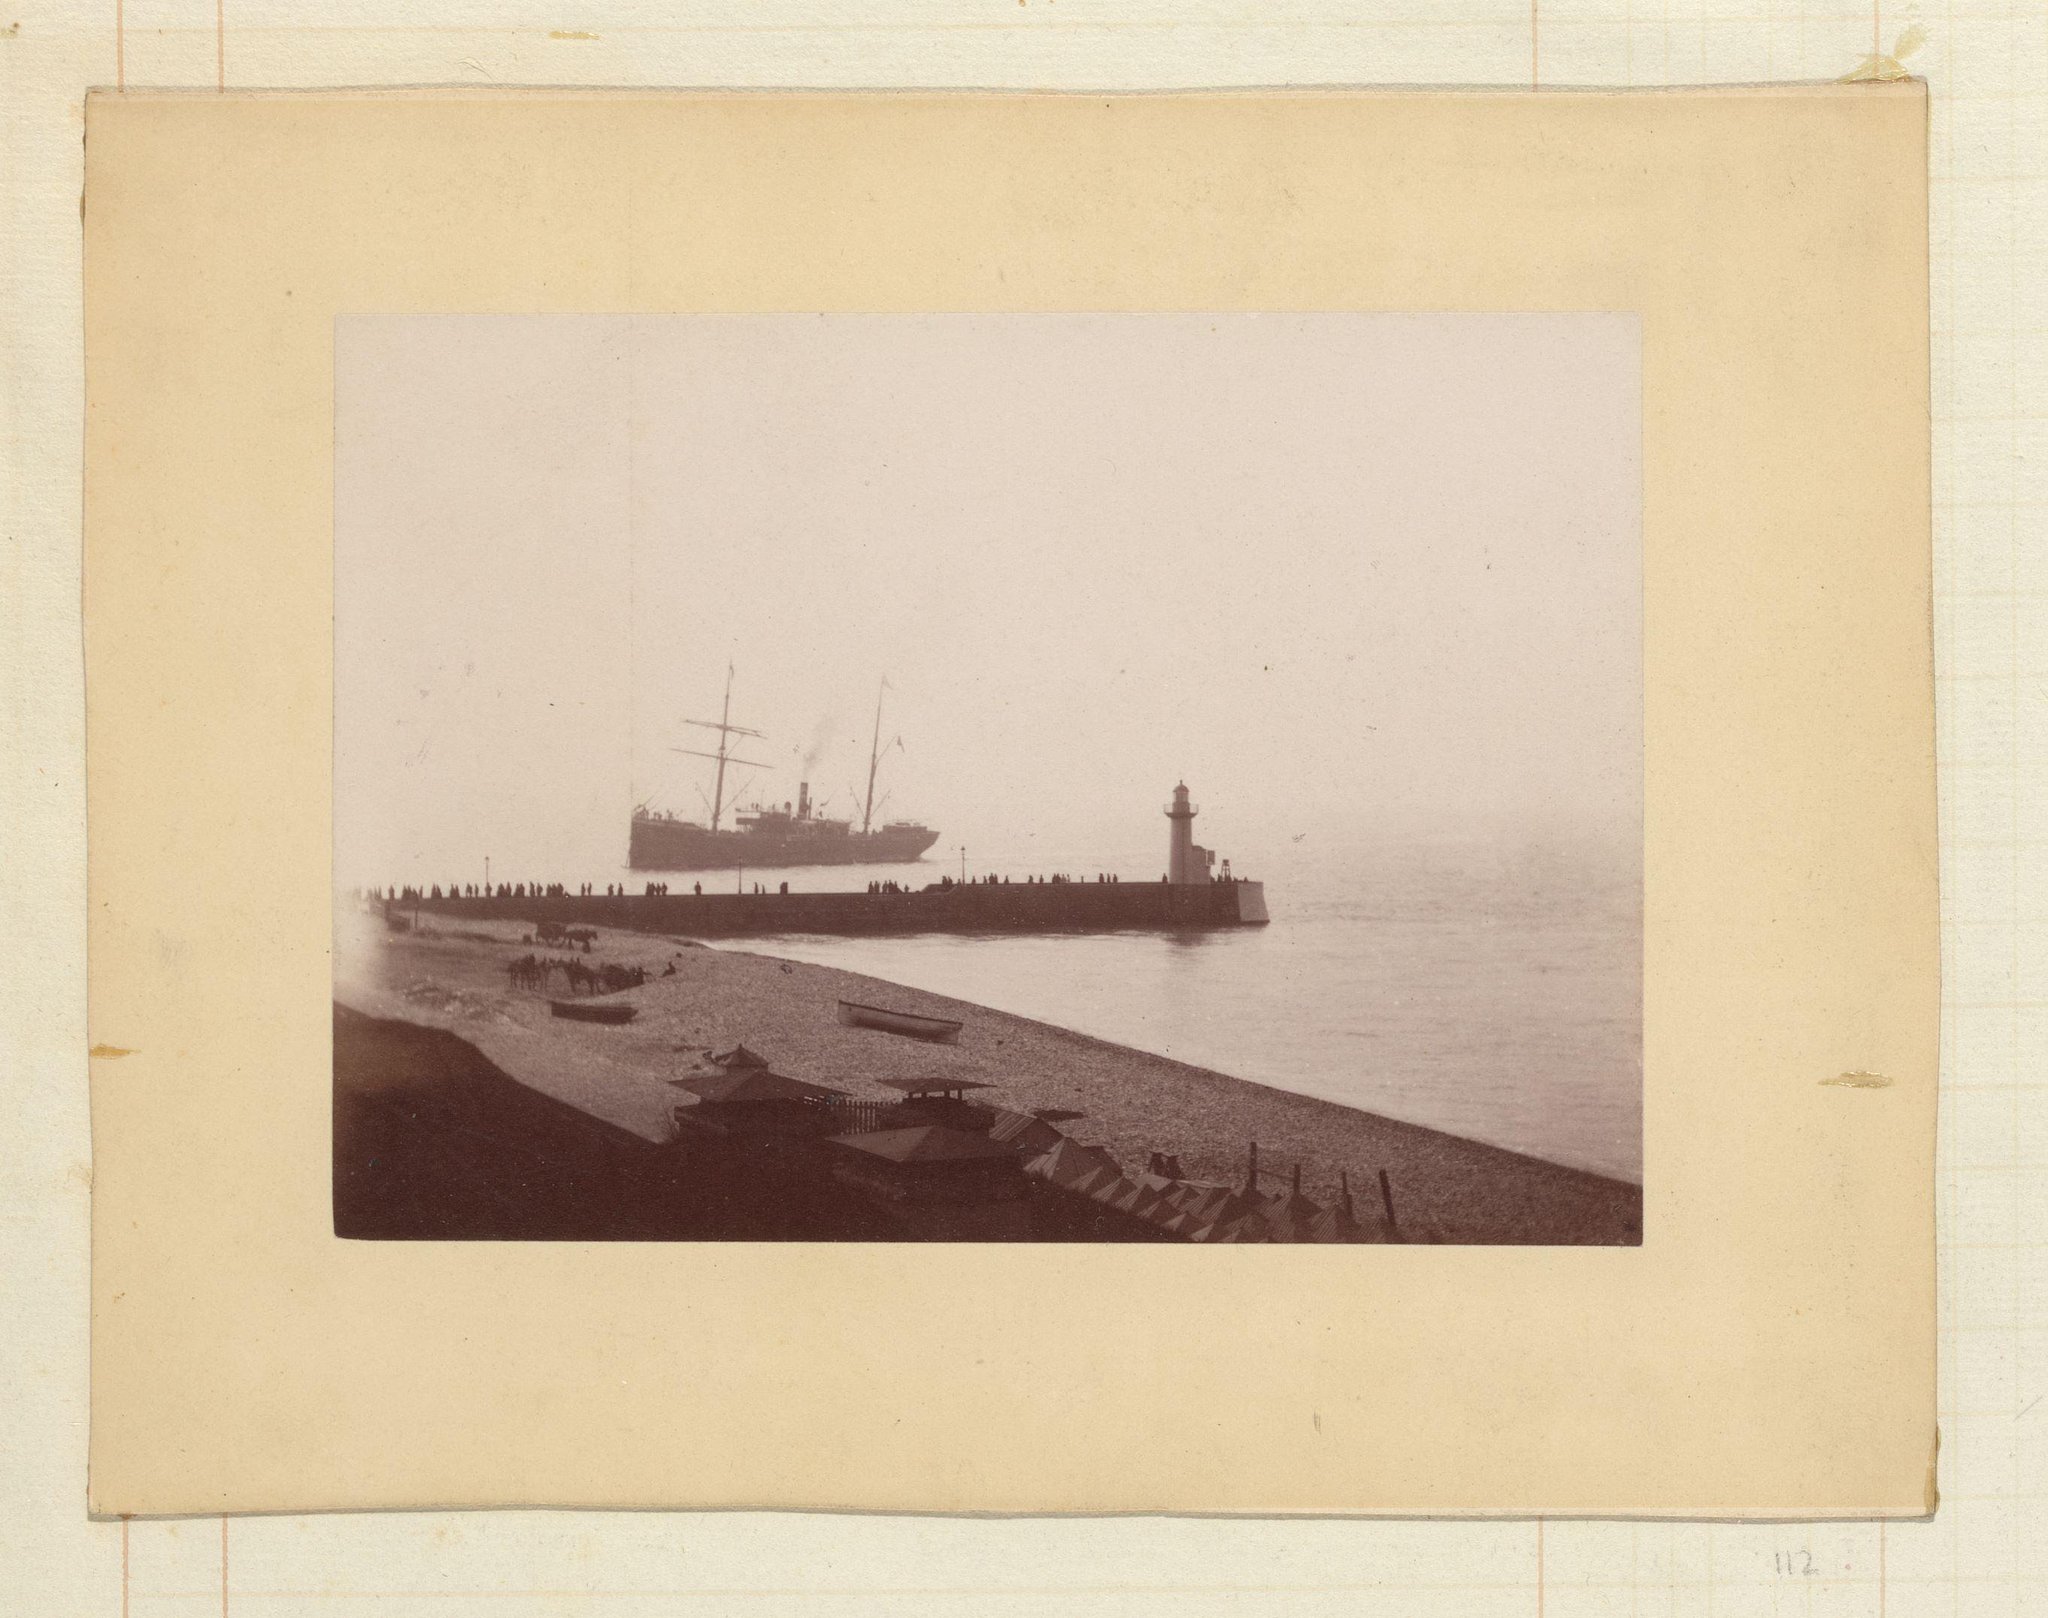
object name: photograph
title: Schip arriveert bij een havenpier met toeschouwers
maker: Anonymous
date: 1880-1900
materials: paper, photographic support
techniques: albumen print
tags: arrival and return ~ travelling, pier, quay, wharf, steamship, motorship